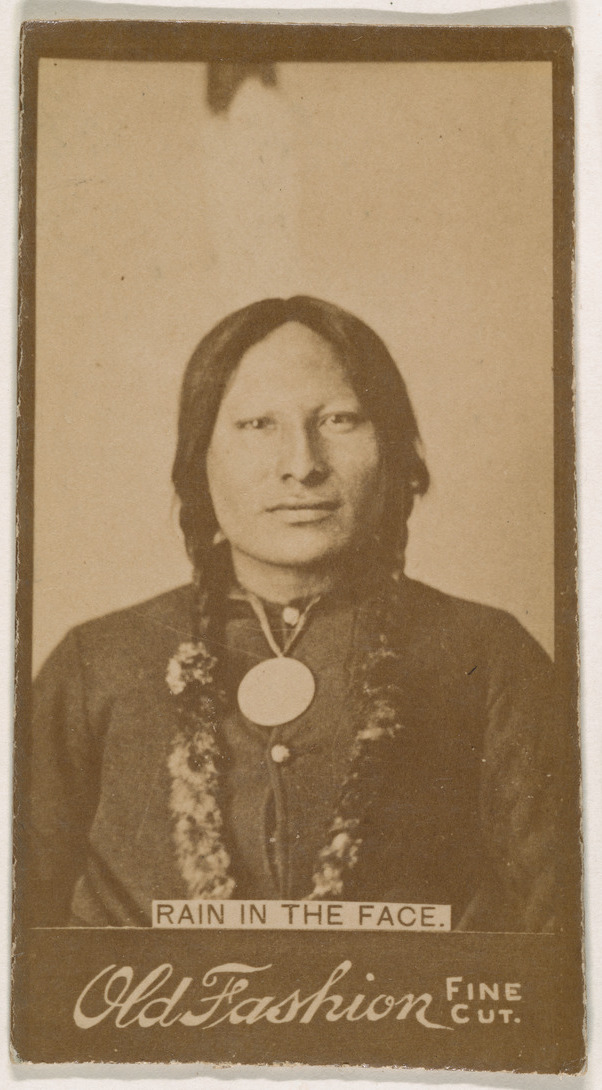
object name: photograph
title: Rain in the Face, from the Indian Chiefs series (N681) promoting Old Fashion Fine Cut Tobacco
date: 1888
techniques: albumen silver print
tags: men,portraits